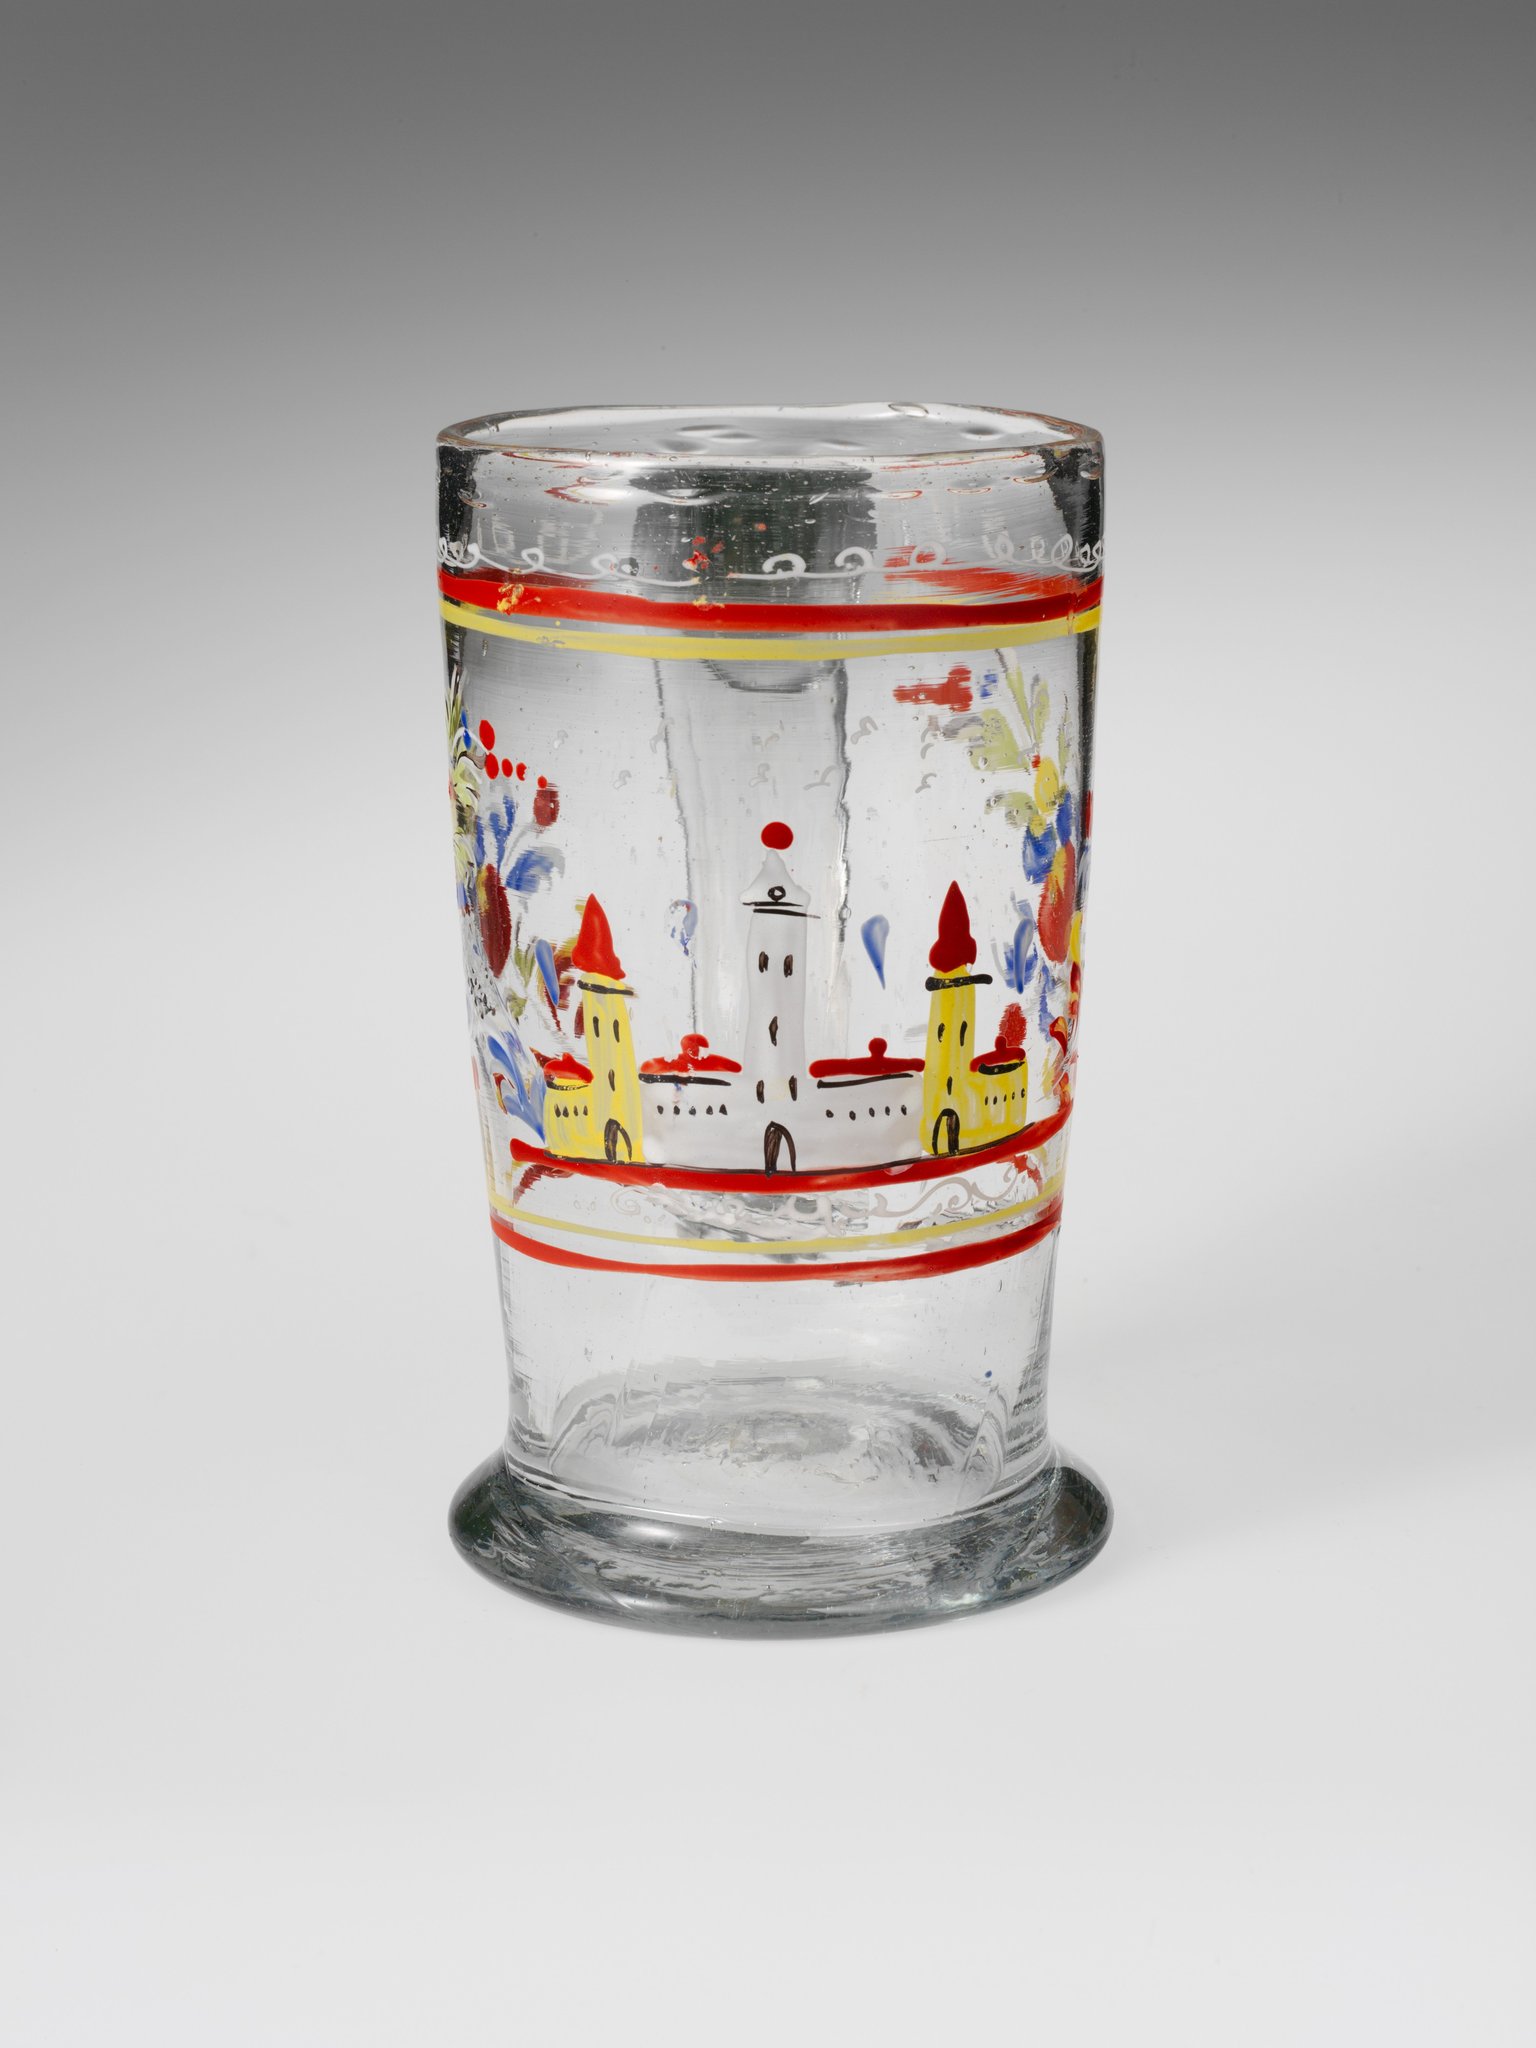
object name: mug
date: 1700-1800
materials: enamel, glass, lead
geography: czech republic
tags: buildings